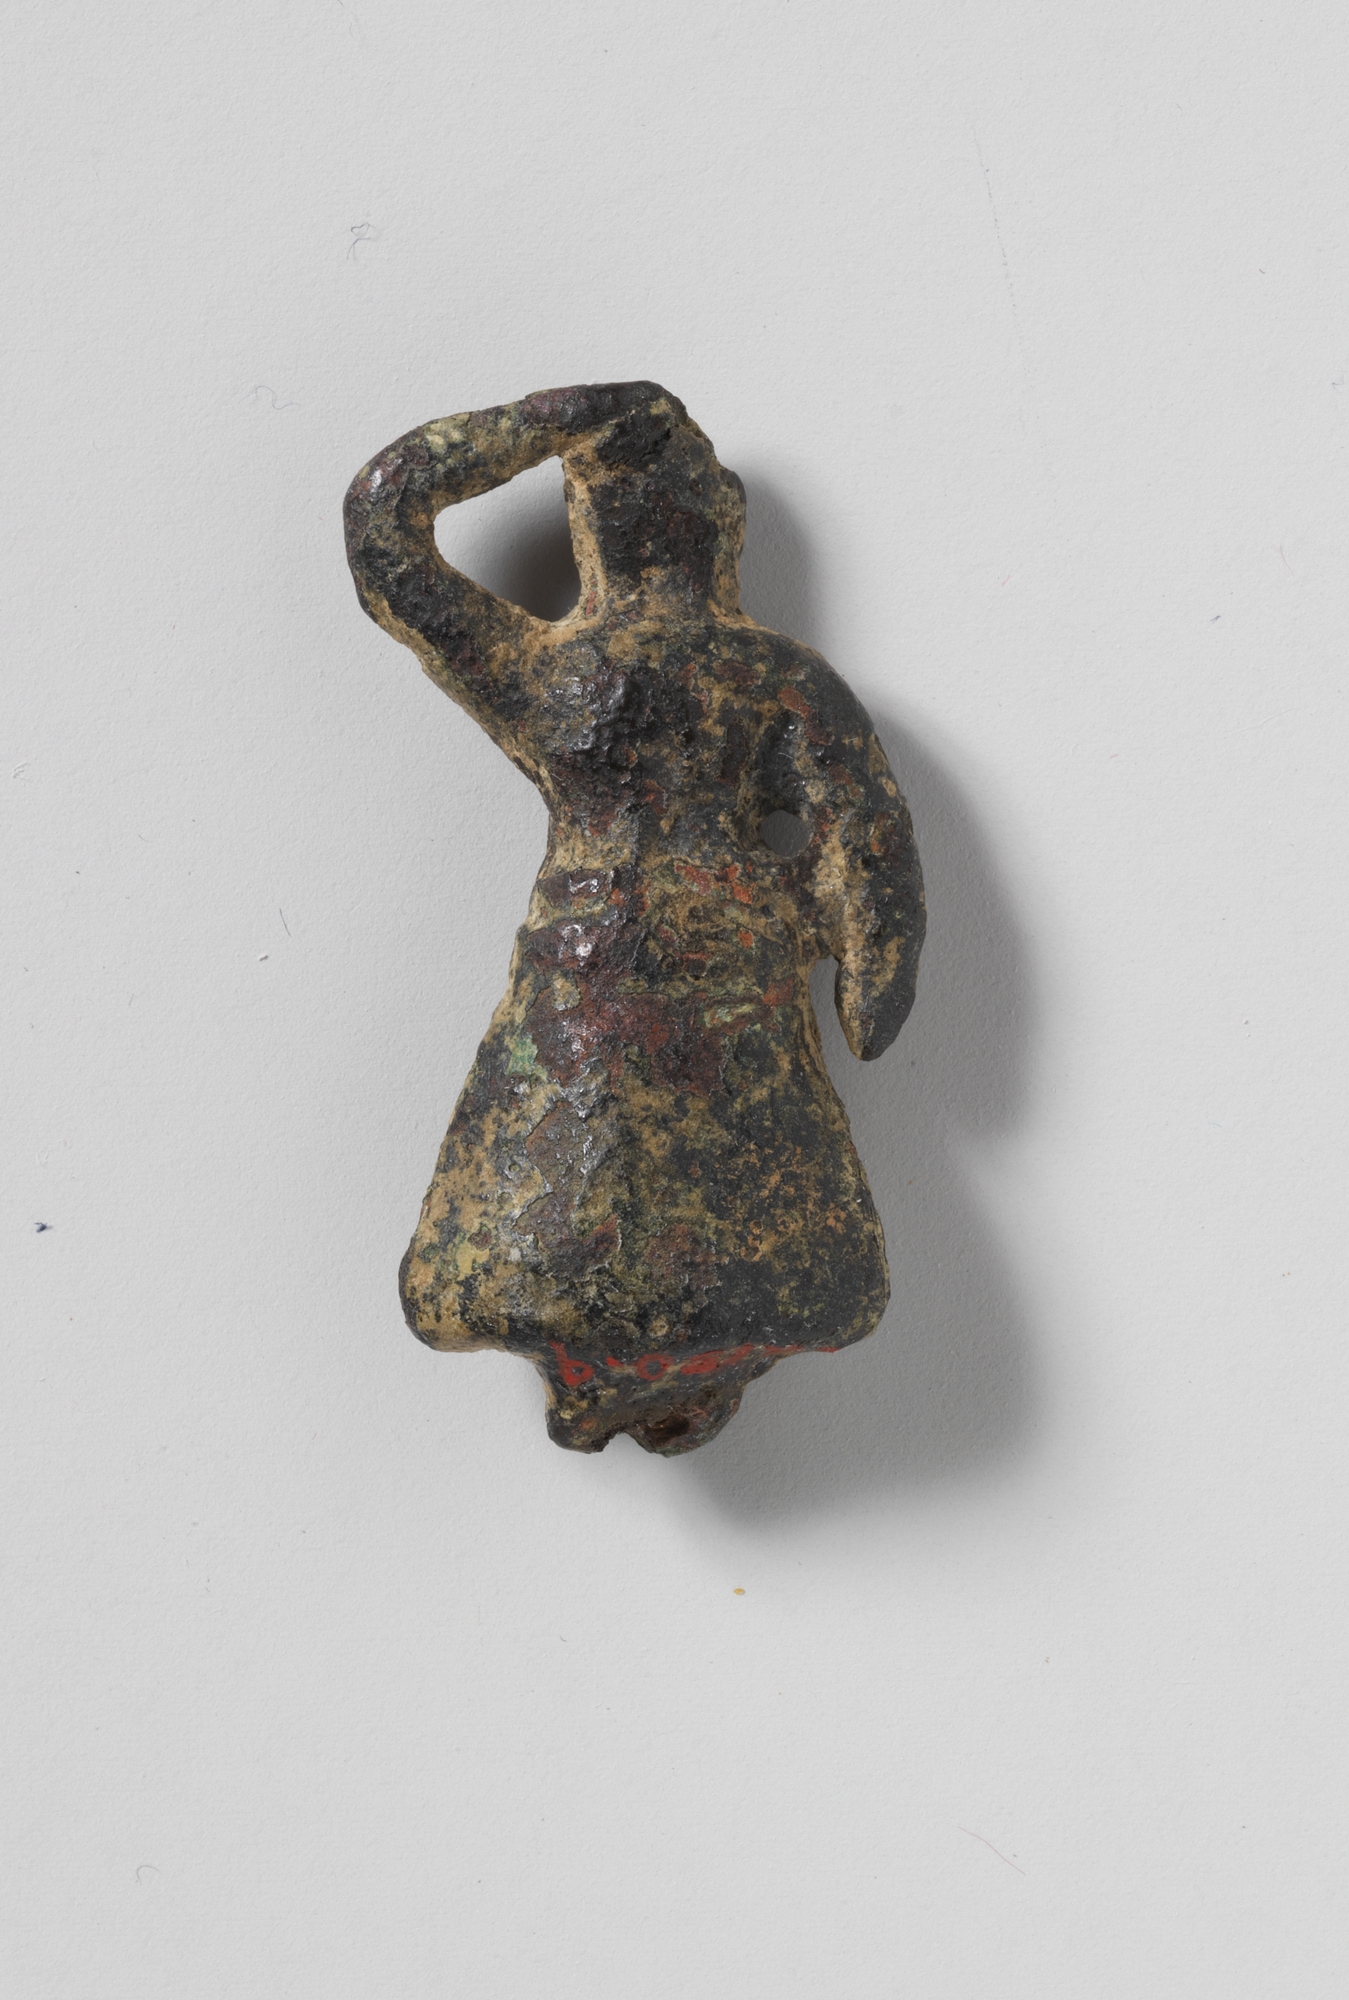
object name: statuette of a woman in adoration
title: Bronze female figure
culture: minoan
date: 1700-1600 BCE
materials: bronze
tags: women